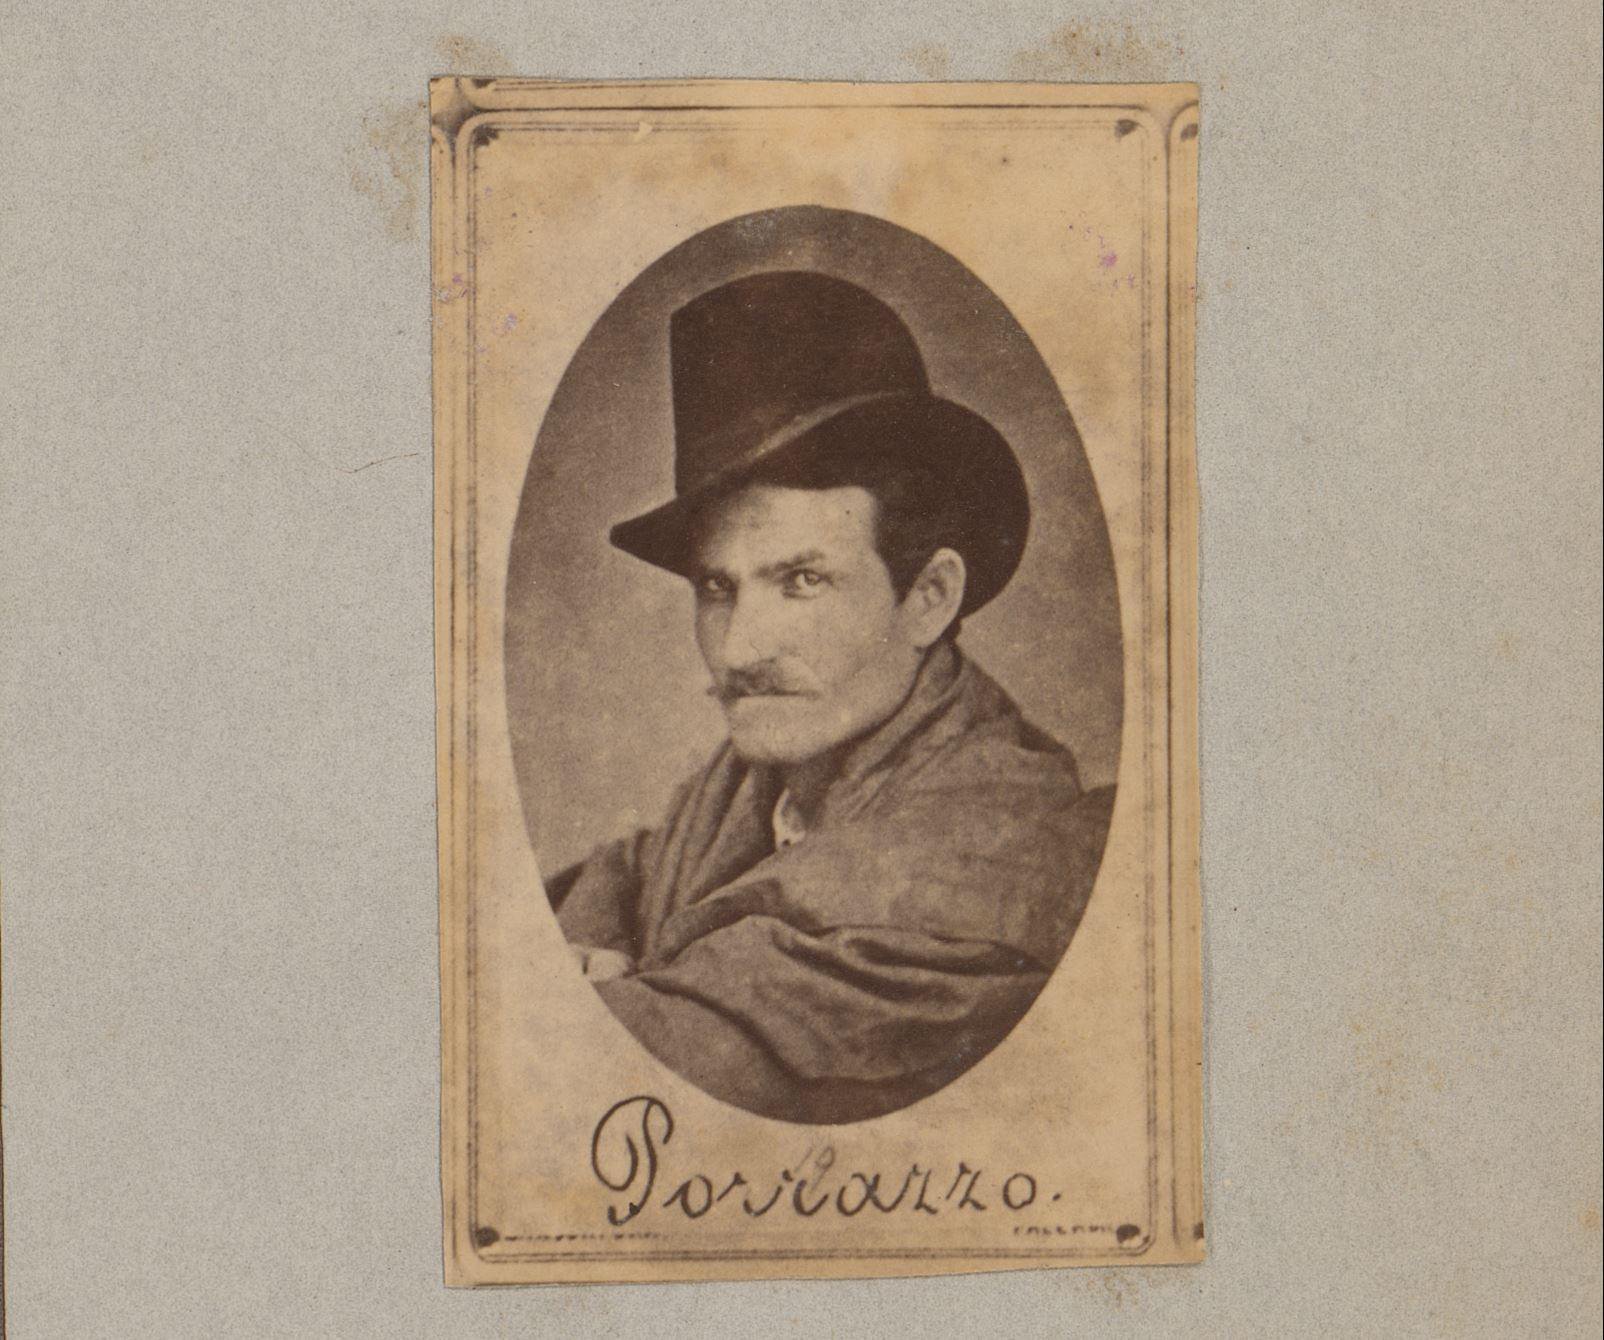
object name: reproduction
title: Fotoreproductie van 'Porrazzo', Siciliaanse brigard, door G. Incorpora, volgens methode Monckhoven (8 sec.)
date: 1887-1888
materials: paper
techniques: albumen print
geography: palermo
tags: adult man, head-gear: hat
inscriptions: inscription: ‘6 Brigards de Sicilie capturés en 1878/ exécutés en 1880 à Palerme./ (Reproductie vergr. pl. Monckhoven 8 sec.)’, inscription: ‘Porrazzo’